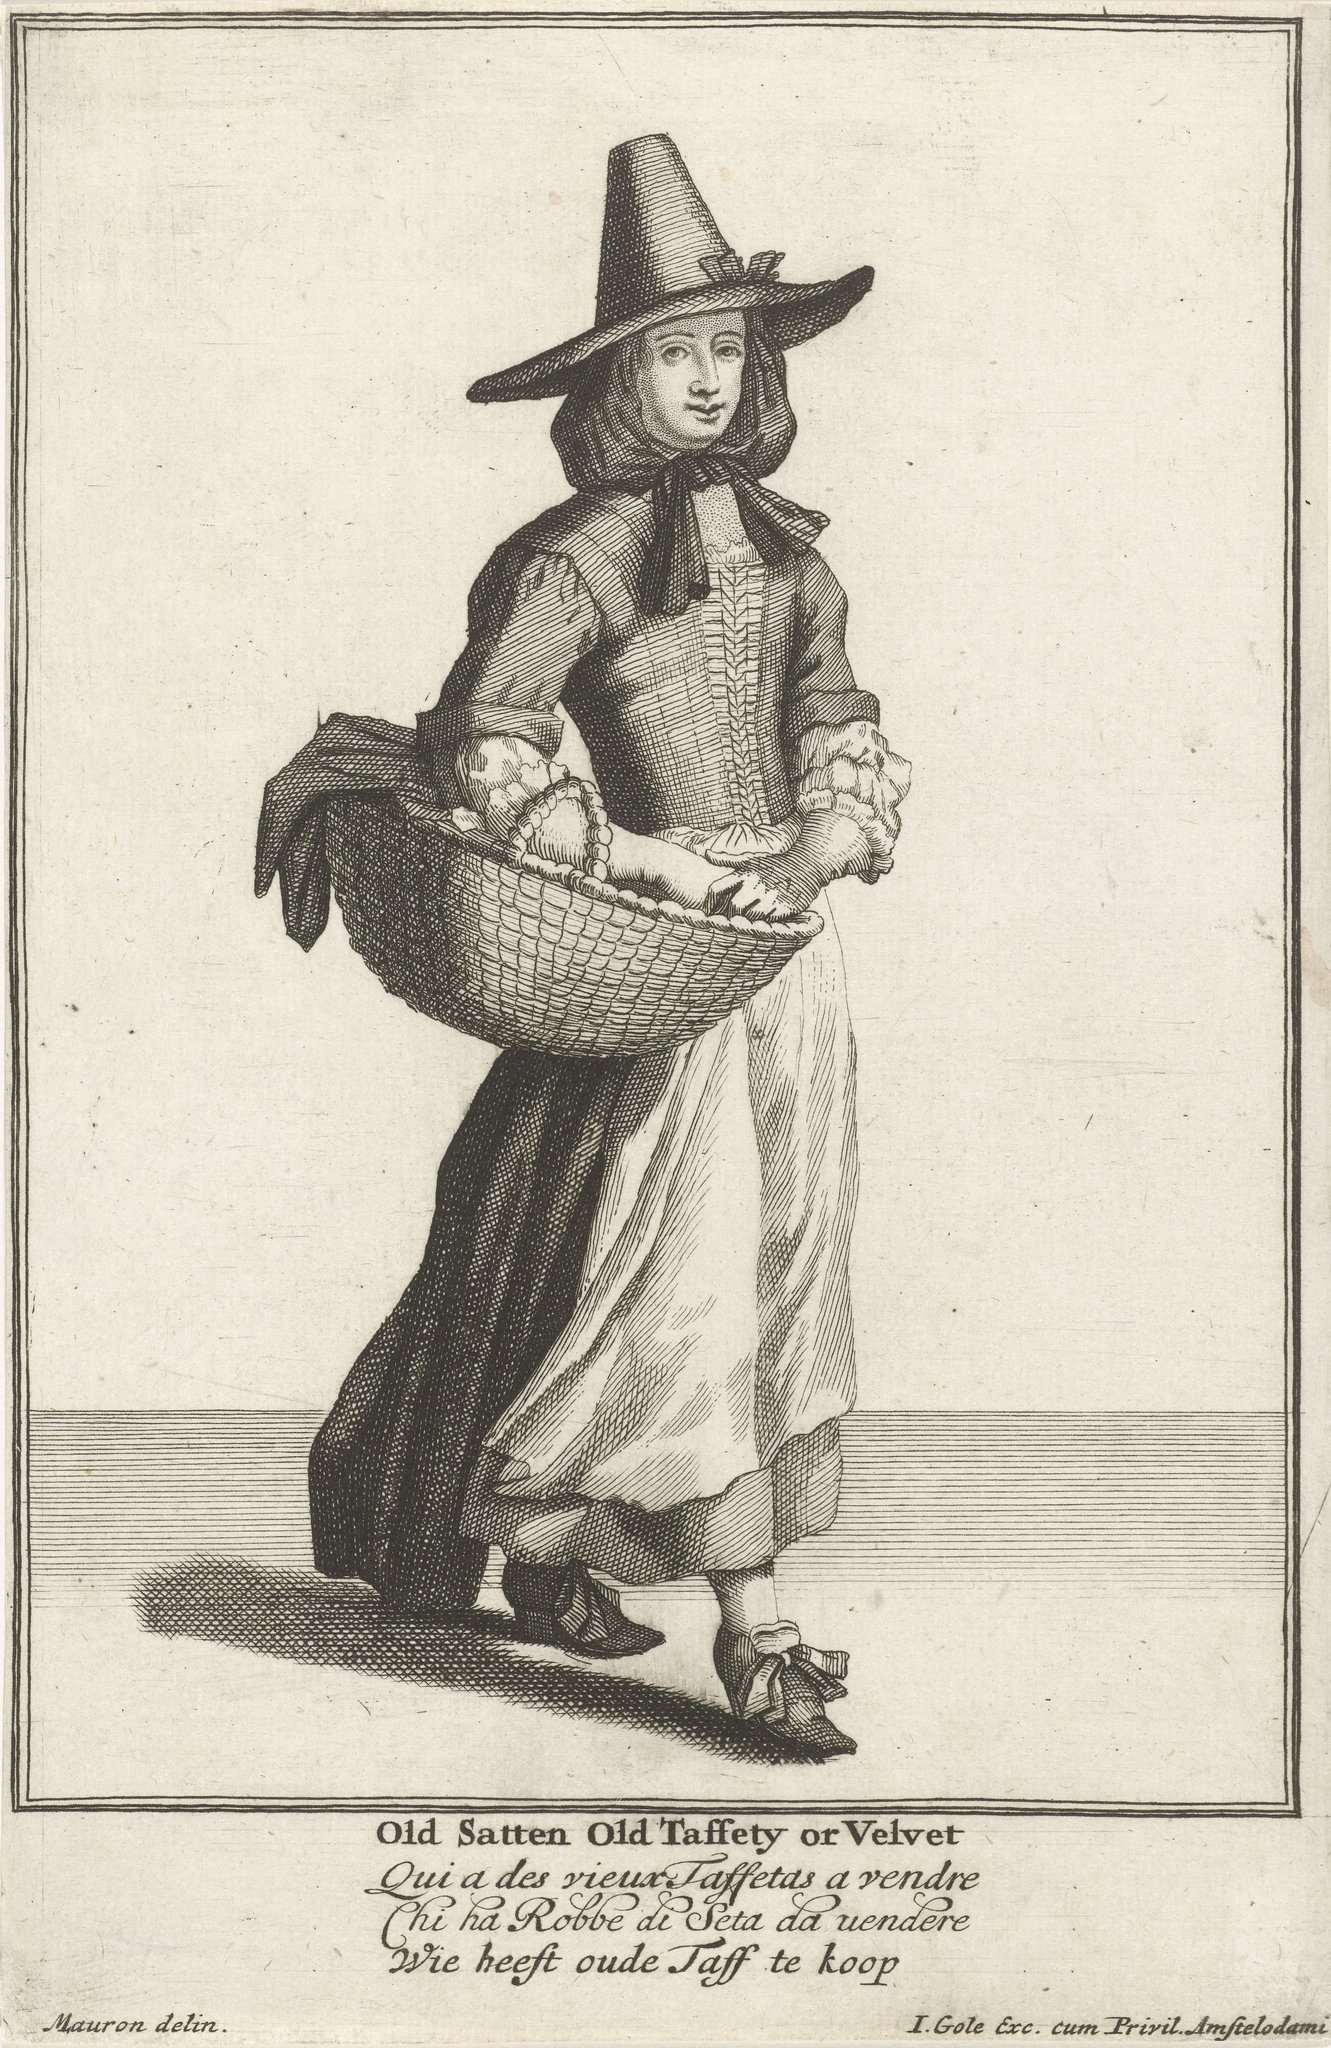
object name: costume print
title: The Cryes of the City of London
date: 1688-1724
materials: paper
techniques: engraving, etching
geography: london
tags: merchant, salesman (with name of trade or profession) - bb - women engaged in trade and commerce, 'cris de paris', cries of london, etc. - bb - women engaged in trade and commerce, london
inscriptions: collector's mark: Lugt 2228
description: Een inkoopster van tweedehandskleding. Ze draagt een hoge hoed en heeft een mand om haar rechterarm. De prent heeft een Engels, Frans, Italiaans en Nederlands onderschrift en maakt deel uit van een serie over de straatventers in Londen.